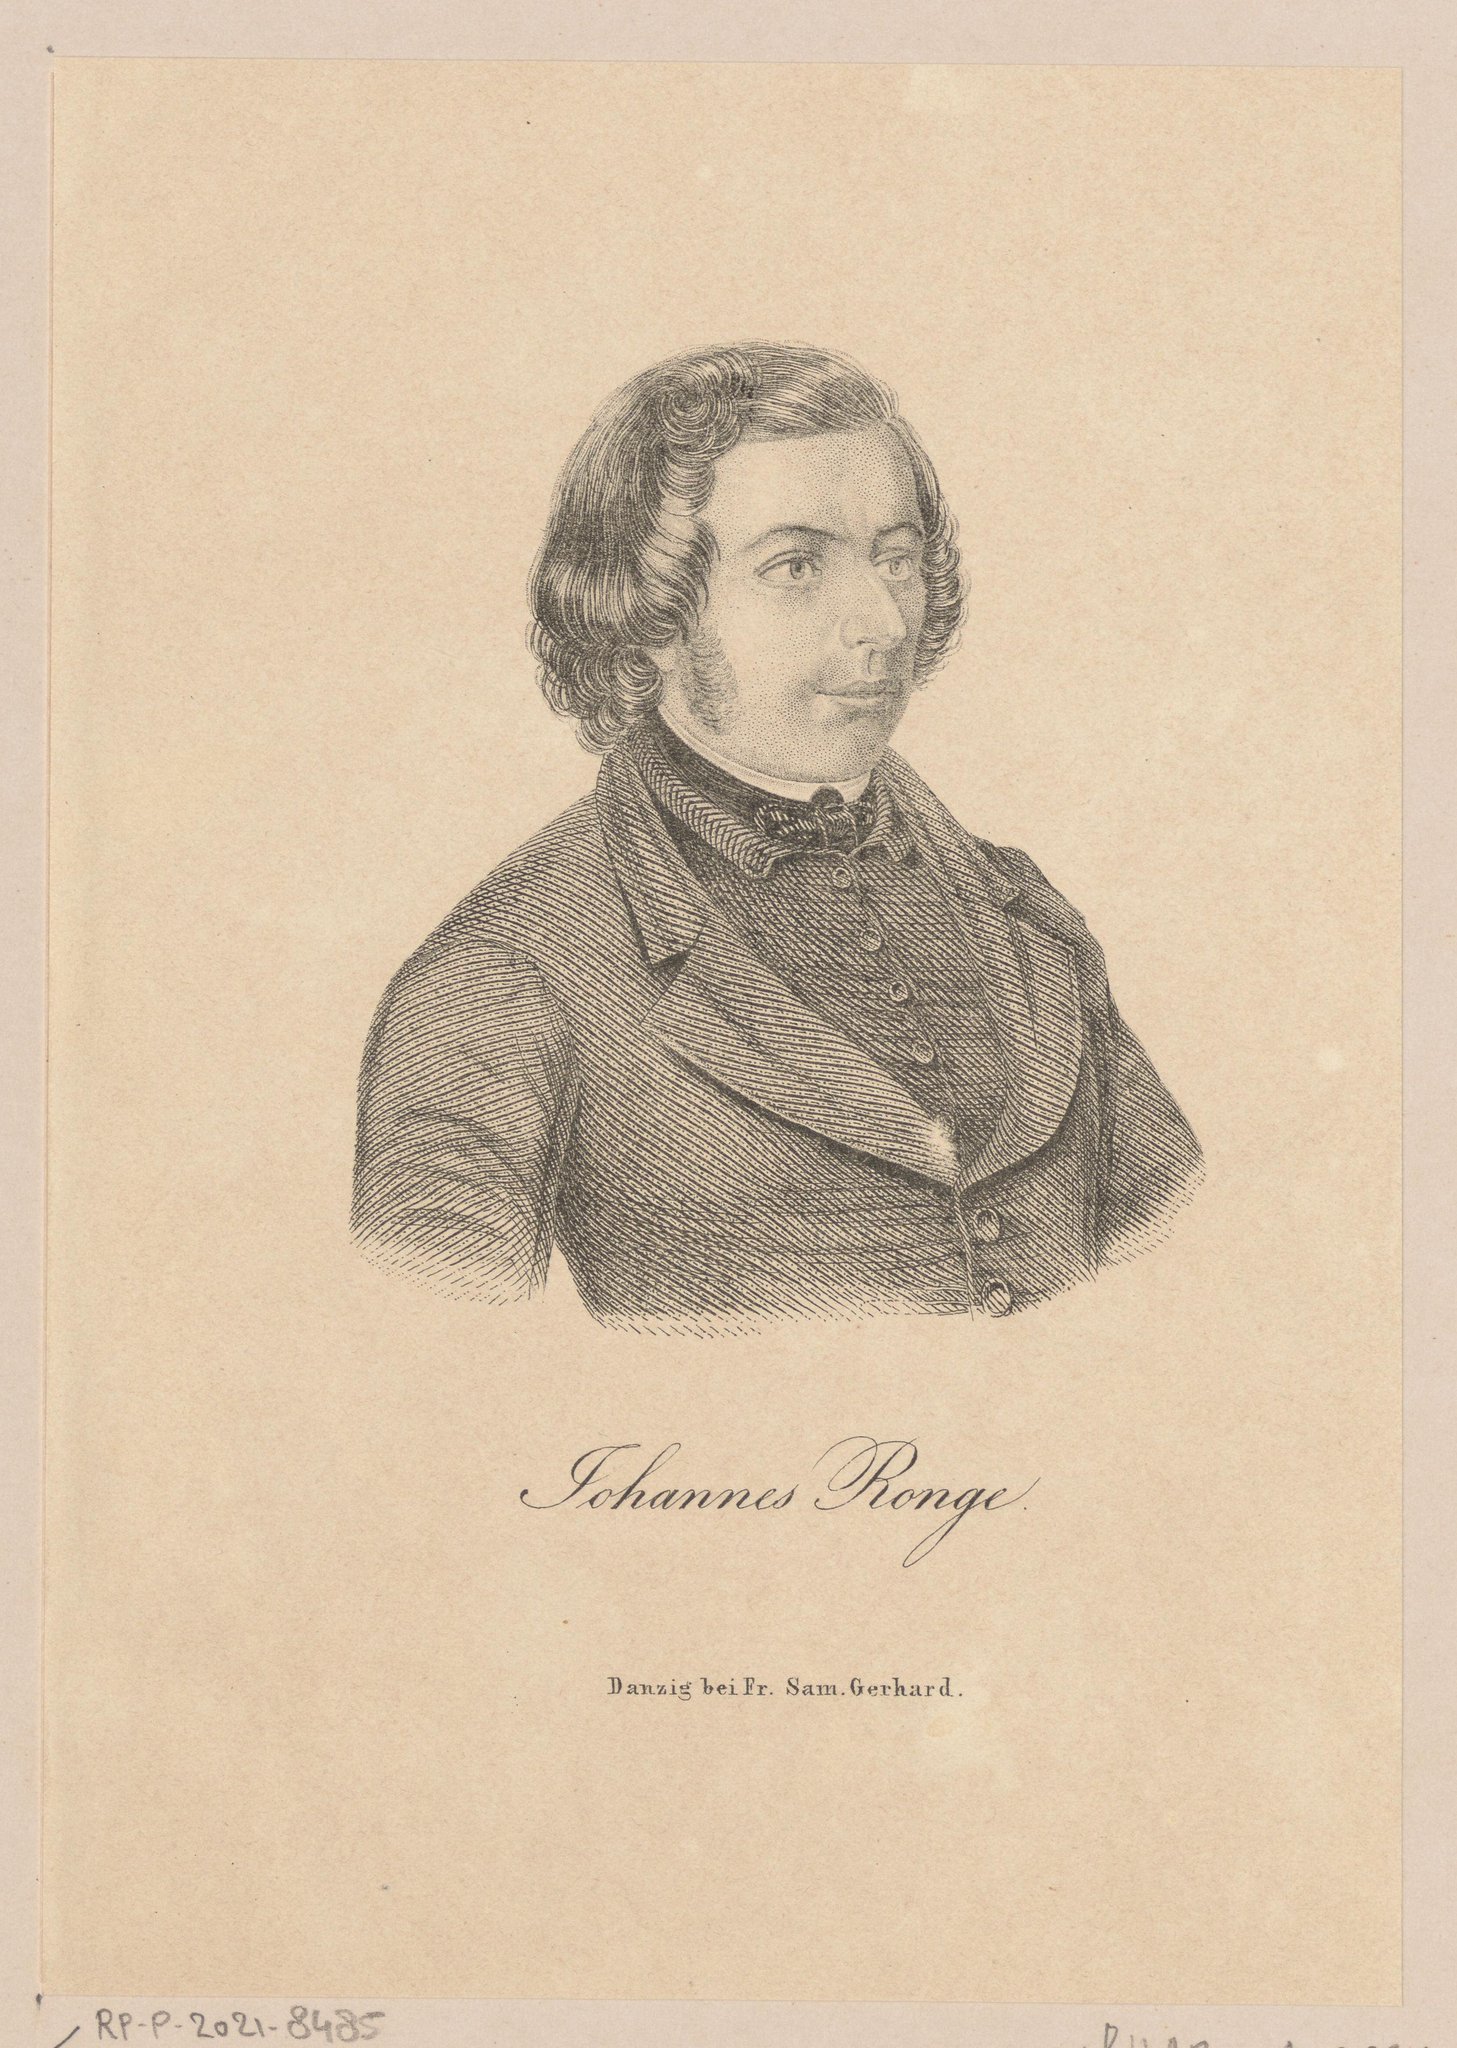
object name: print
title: Portret van Johannes Ronge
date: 1833-1899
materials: paper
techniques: engraving, etching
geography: danzig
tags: vienna, historical persons